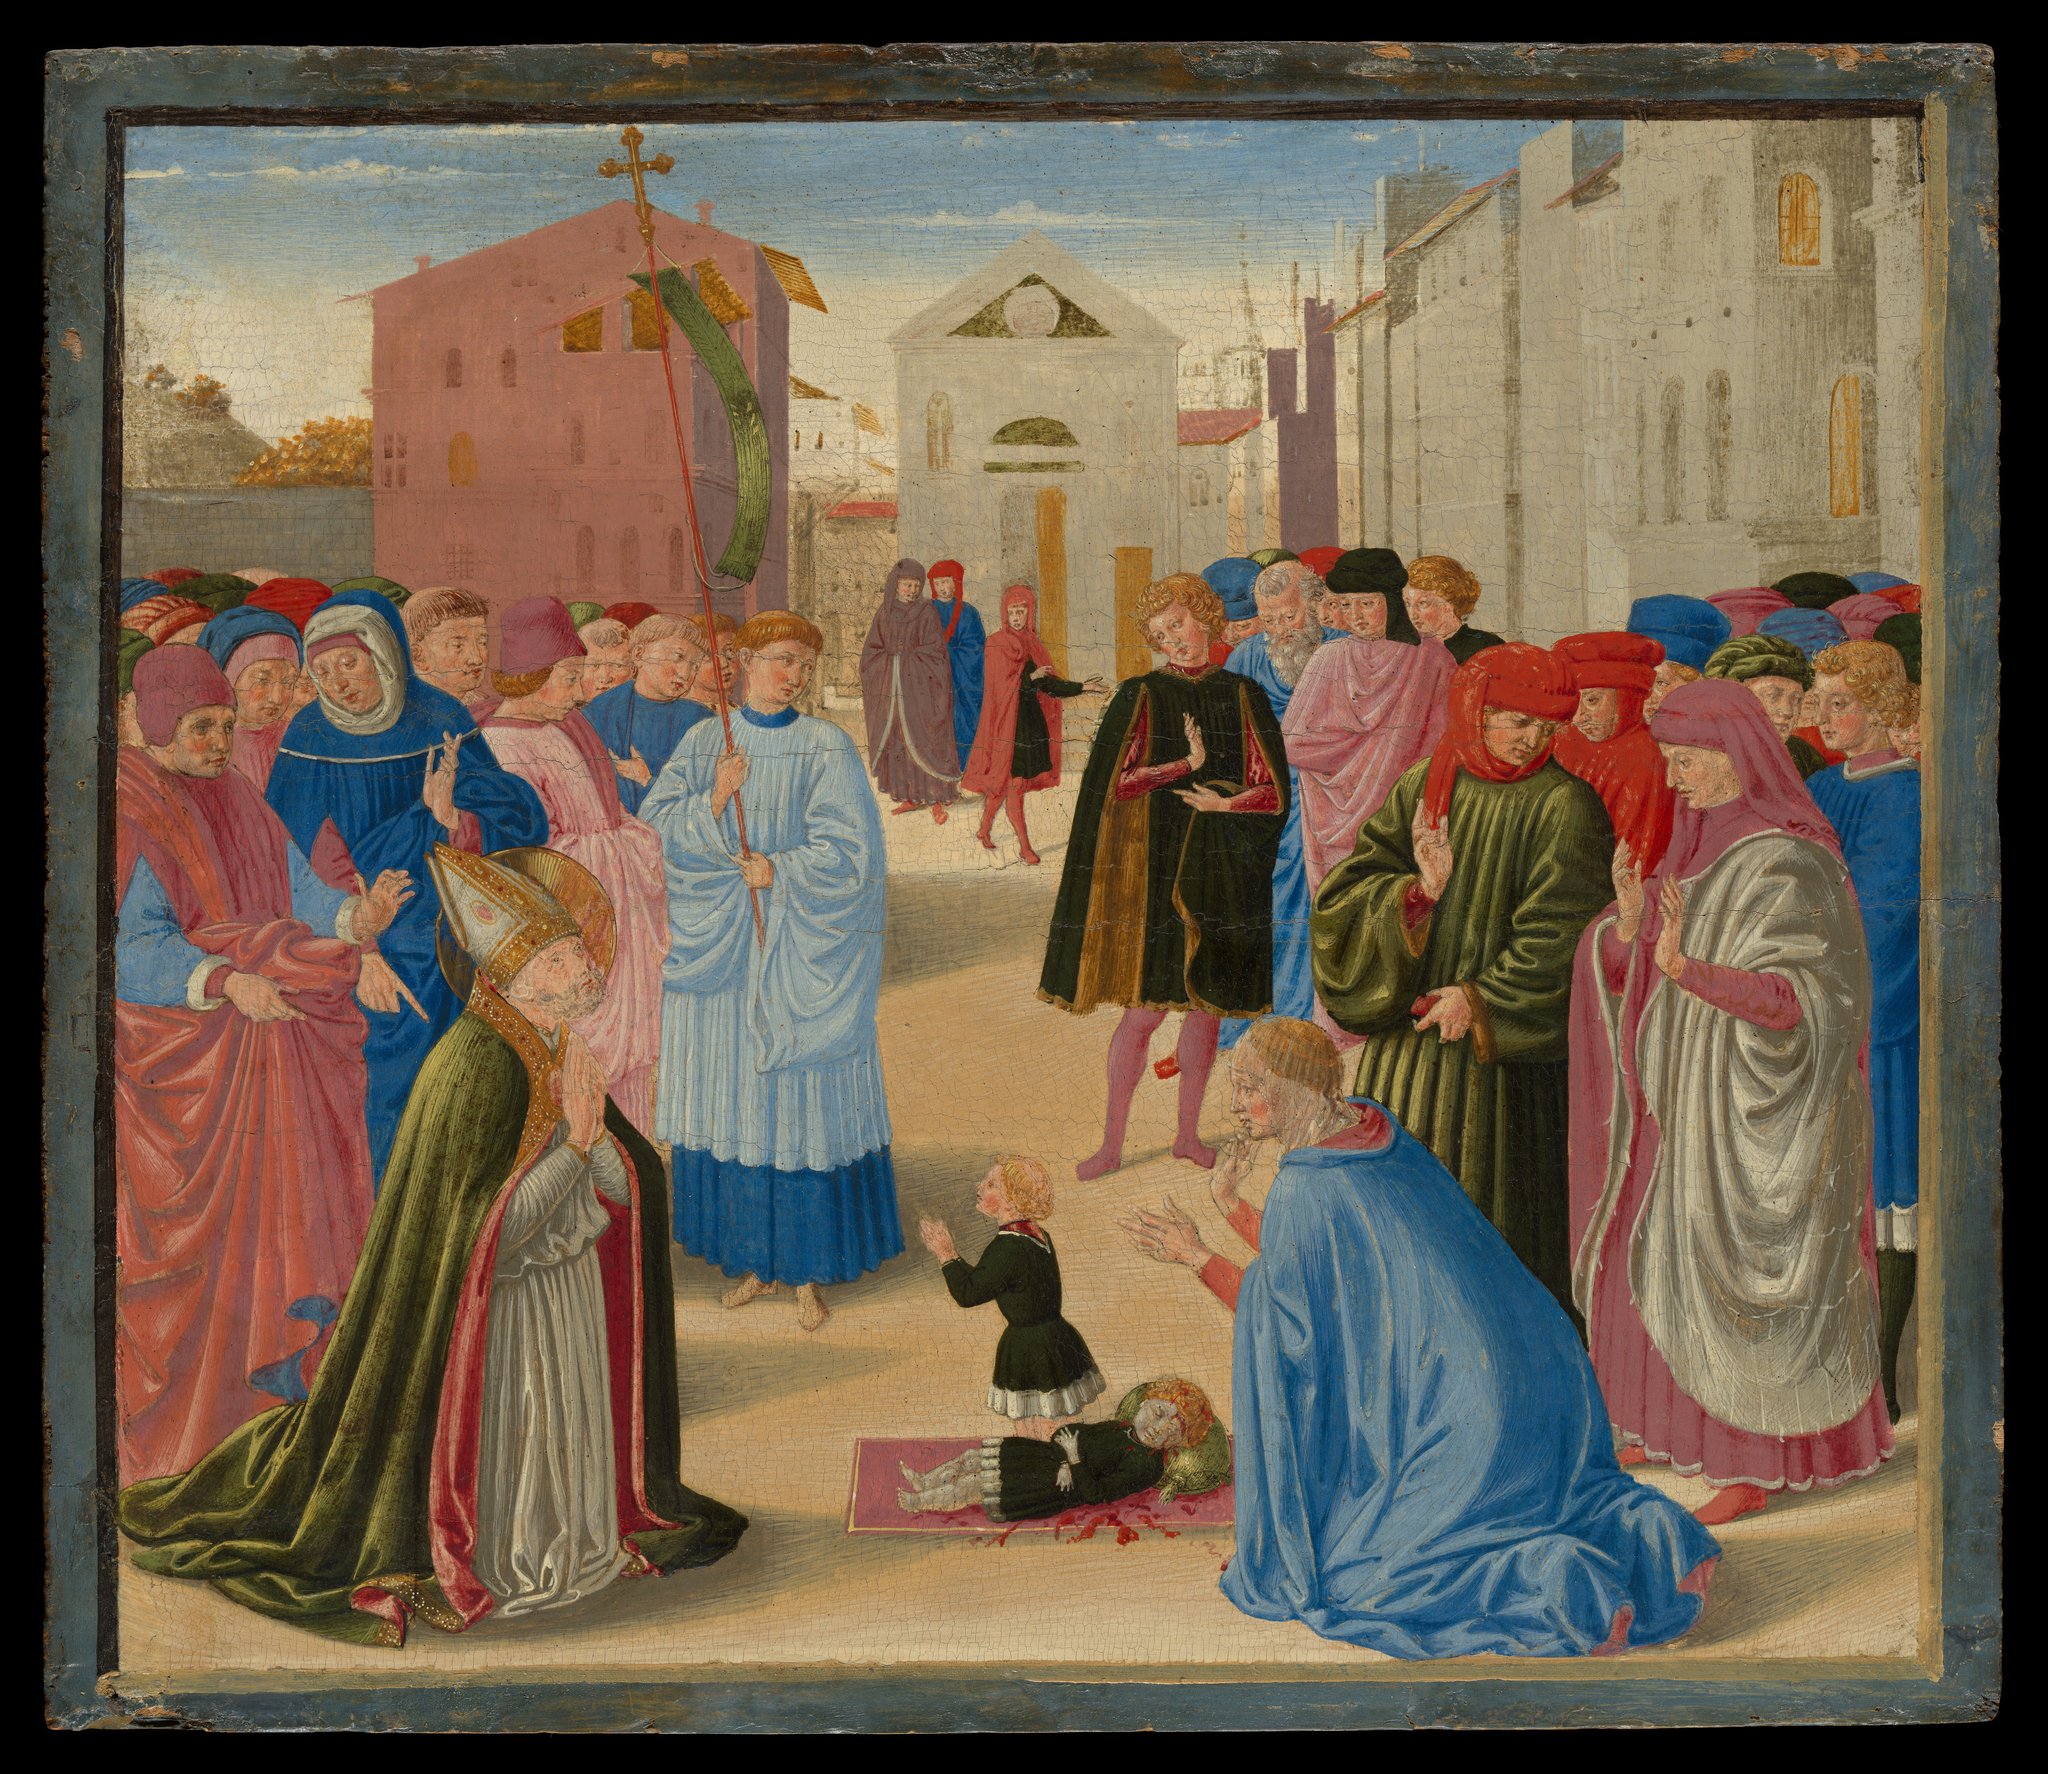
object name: painting, predella panel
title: Saint Zenobius Resuscitating a Dead Child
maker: benozzo gozzoli (benozzo di lese di sandro)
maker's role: artist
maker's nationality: italian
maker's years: 1420-1497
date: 1440-1497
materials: paint, wood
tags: children,men,women,saints,death